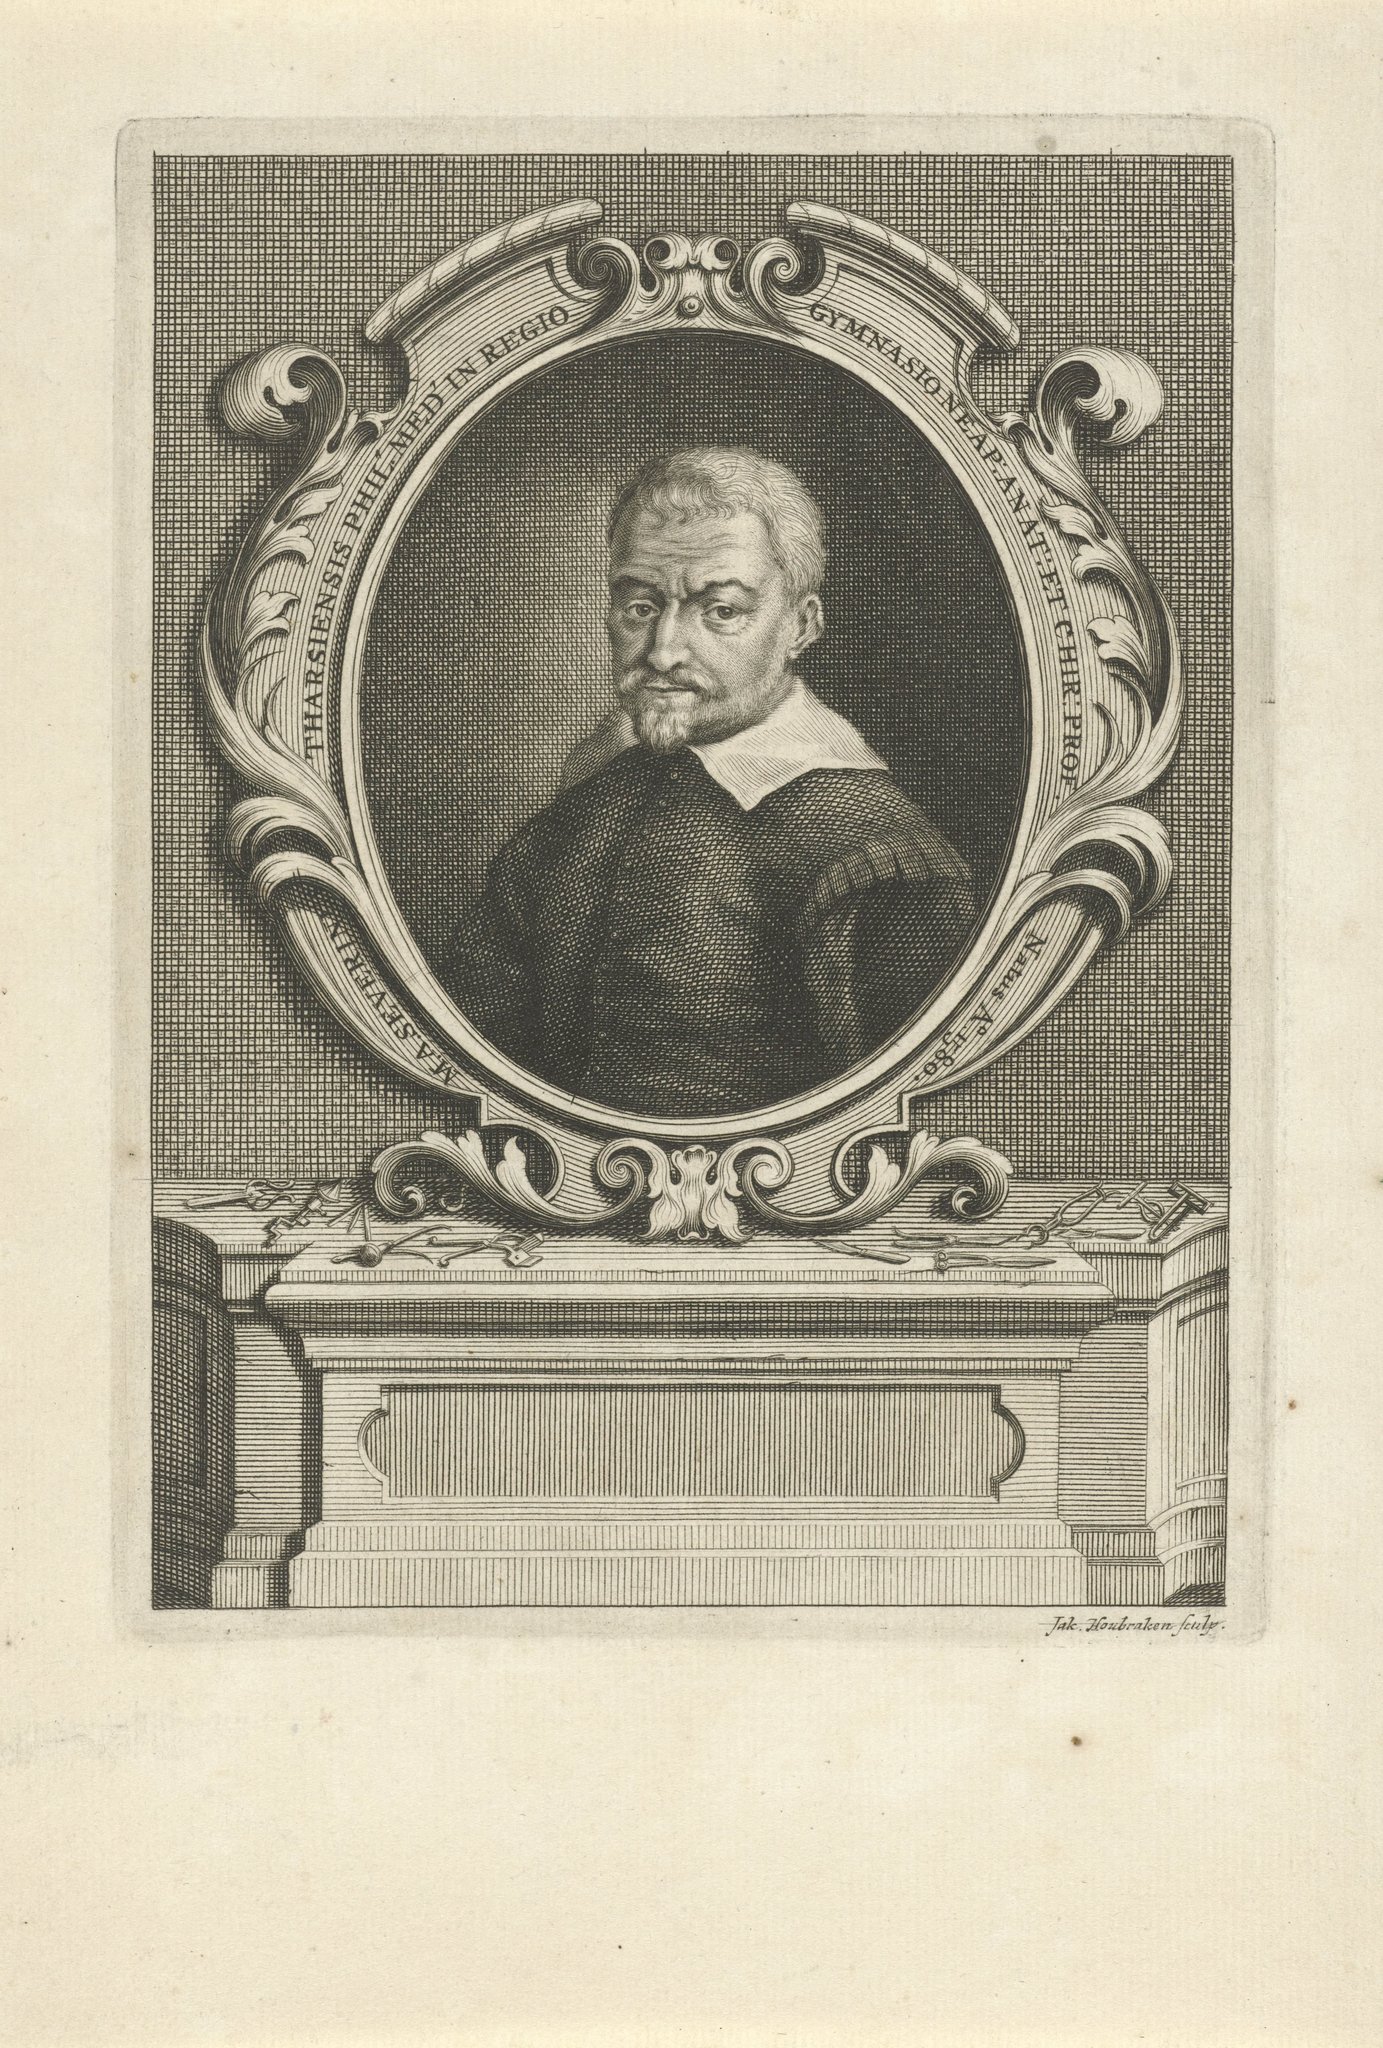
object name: print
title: Portret van Marco Aurelio Severino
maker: jacob houbraken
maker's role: draughtsman, print maker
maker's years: 1698-1780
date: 1724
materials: paper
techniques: engraving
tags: cosenza, naples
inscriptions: collector's mark: Lugt 2228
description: Buste naar links van Marco Aurelio Severino in een ovaal ornamenteel medaillon met randschrift in het Latijn, rustend op een piëdestal. Op de sokkel, rond het portret, tevens verschillende chirurgische instrumenten.